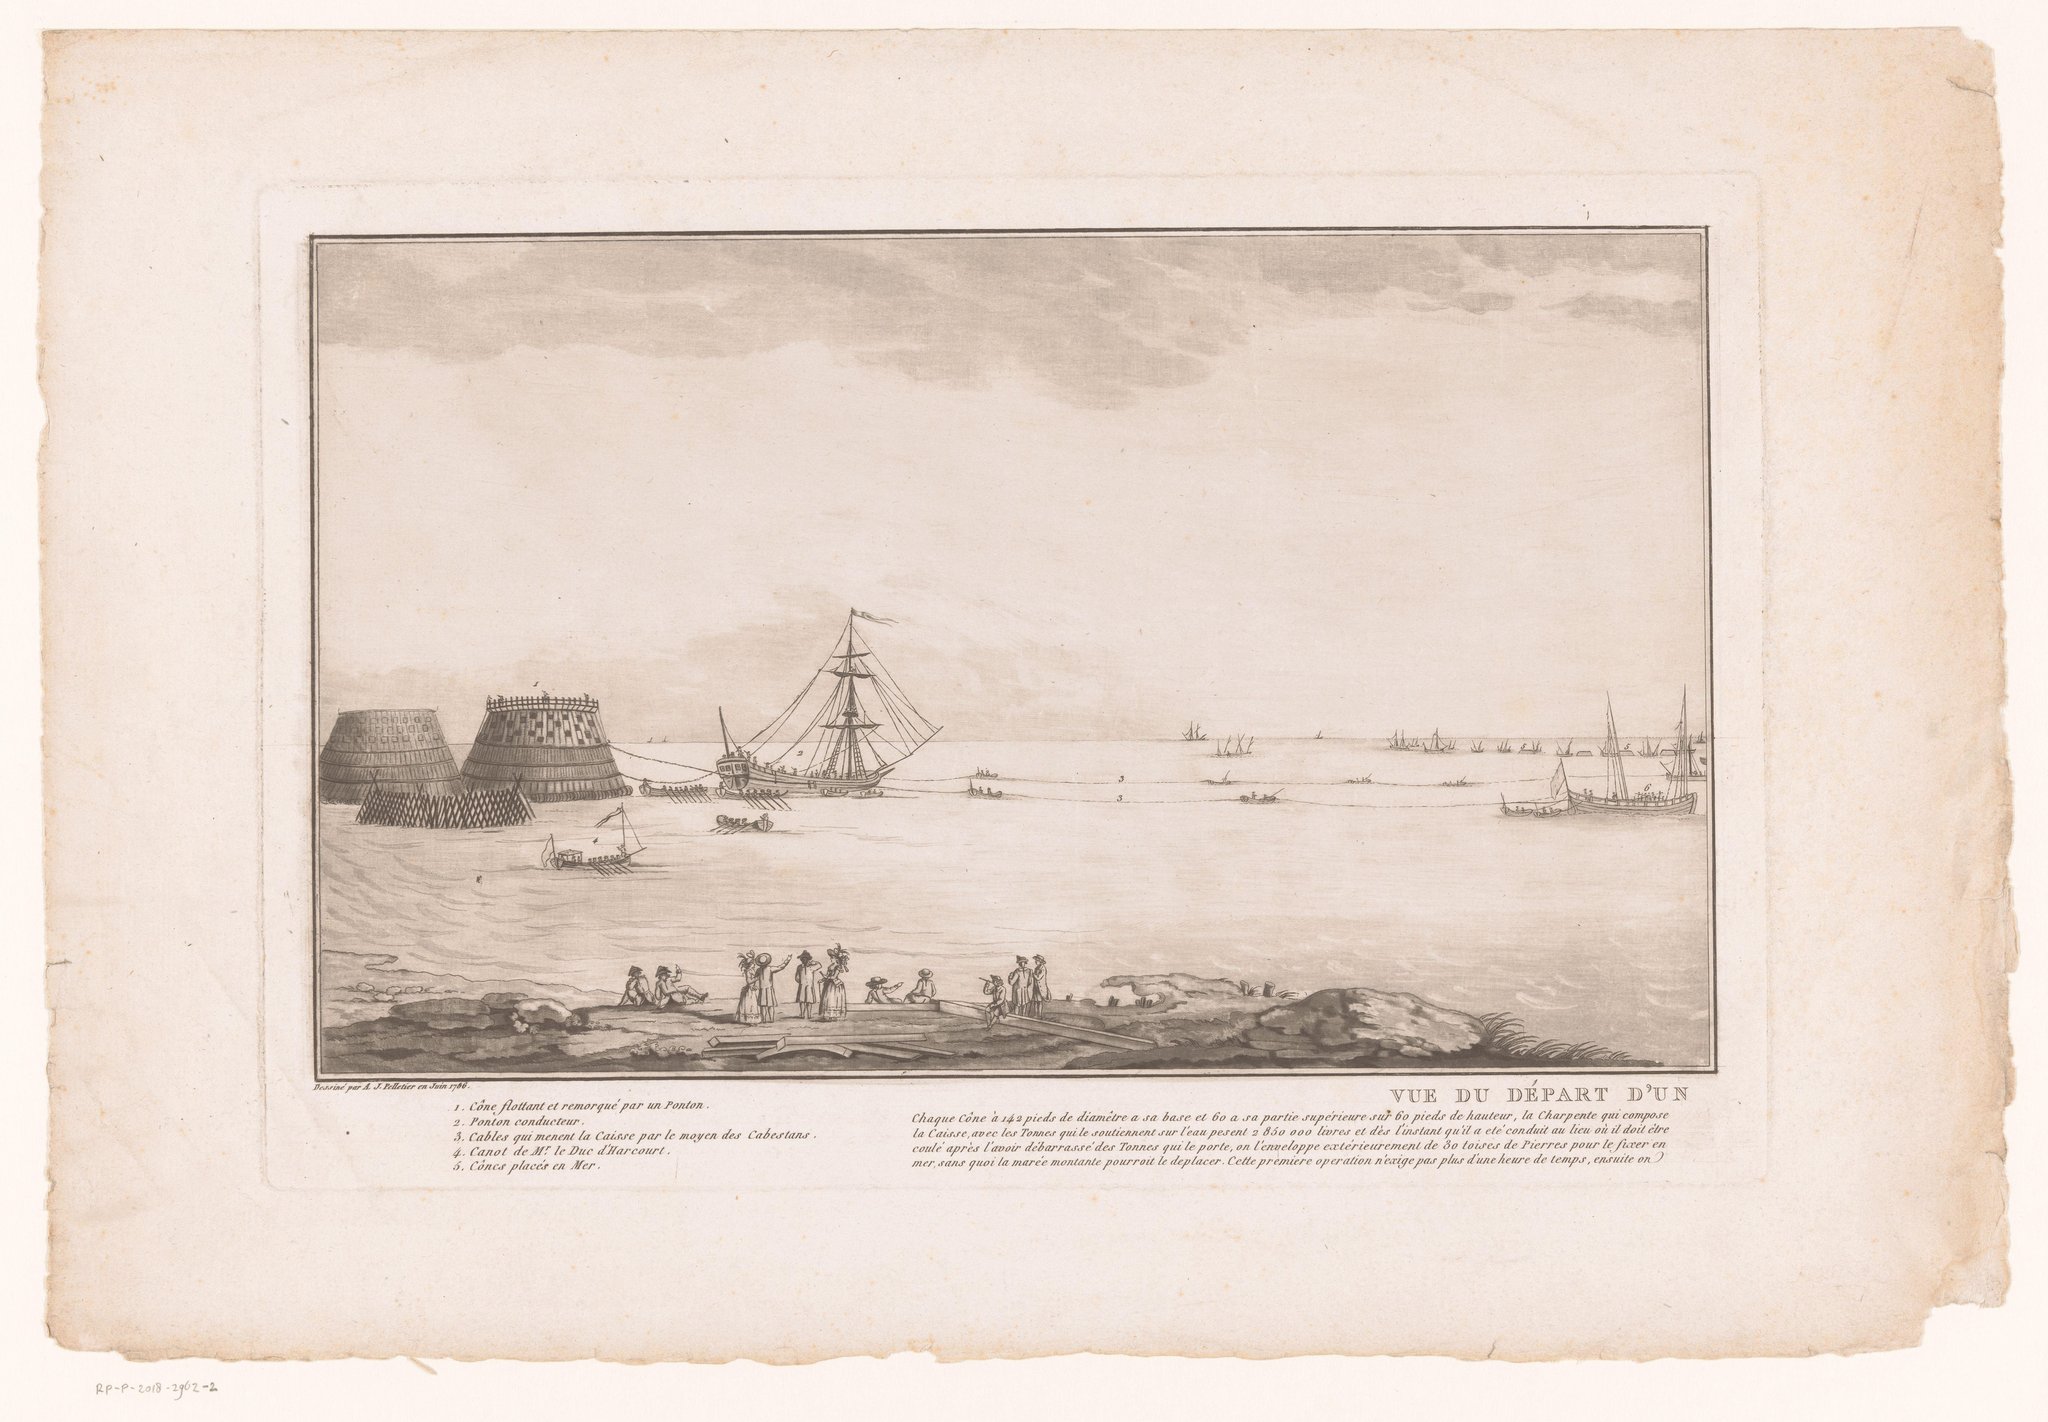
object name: print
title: Vertrek van een boot bij de scheepswerf (blad links)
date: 1786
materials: paper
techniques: aquatint, etching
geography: paris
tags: harbour, pier, quay, wharf, france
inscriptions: collector's mark: Lugt 2228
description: Gezicht op het water vanaf de scheepswerf. Één boot vertrekt.